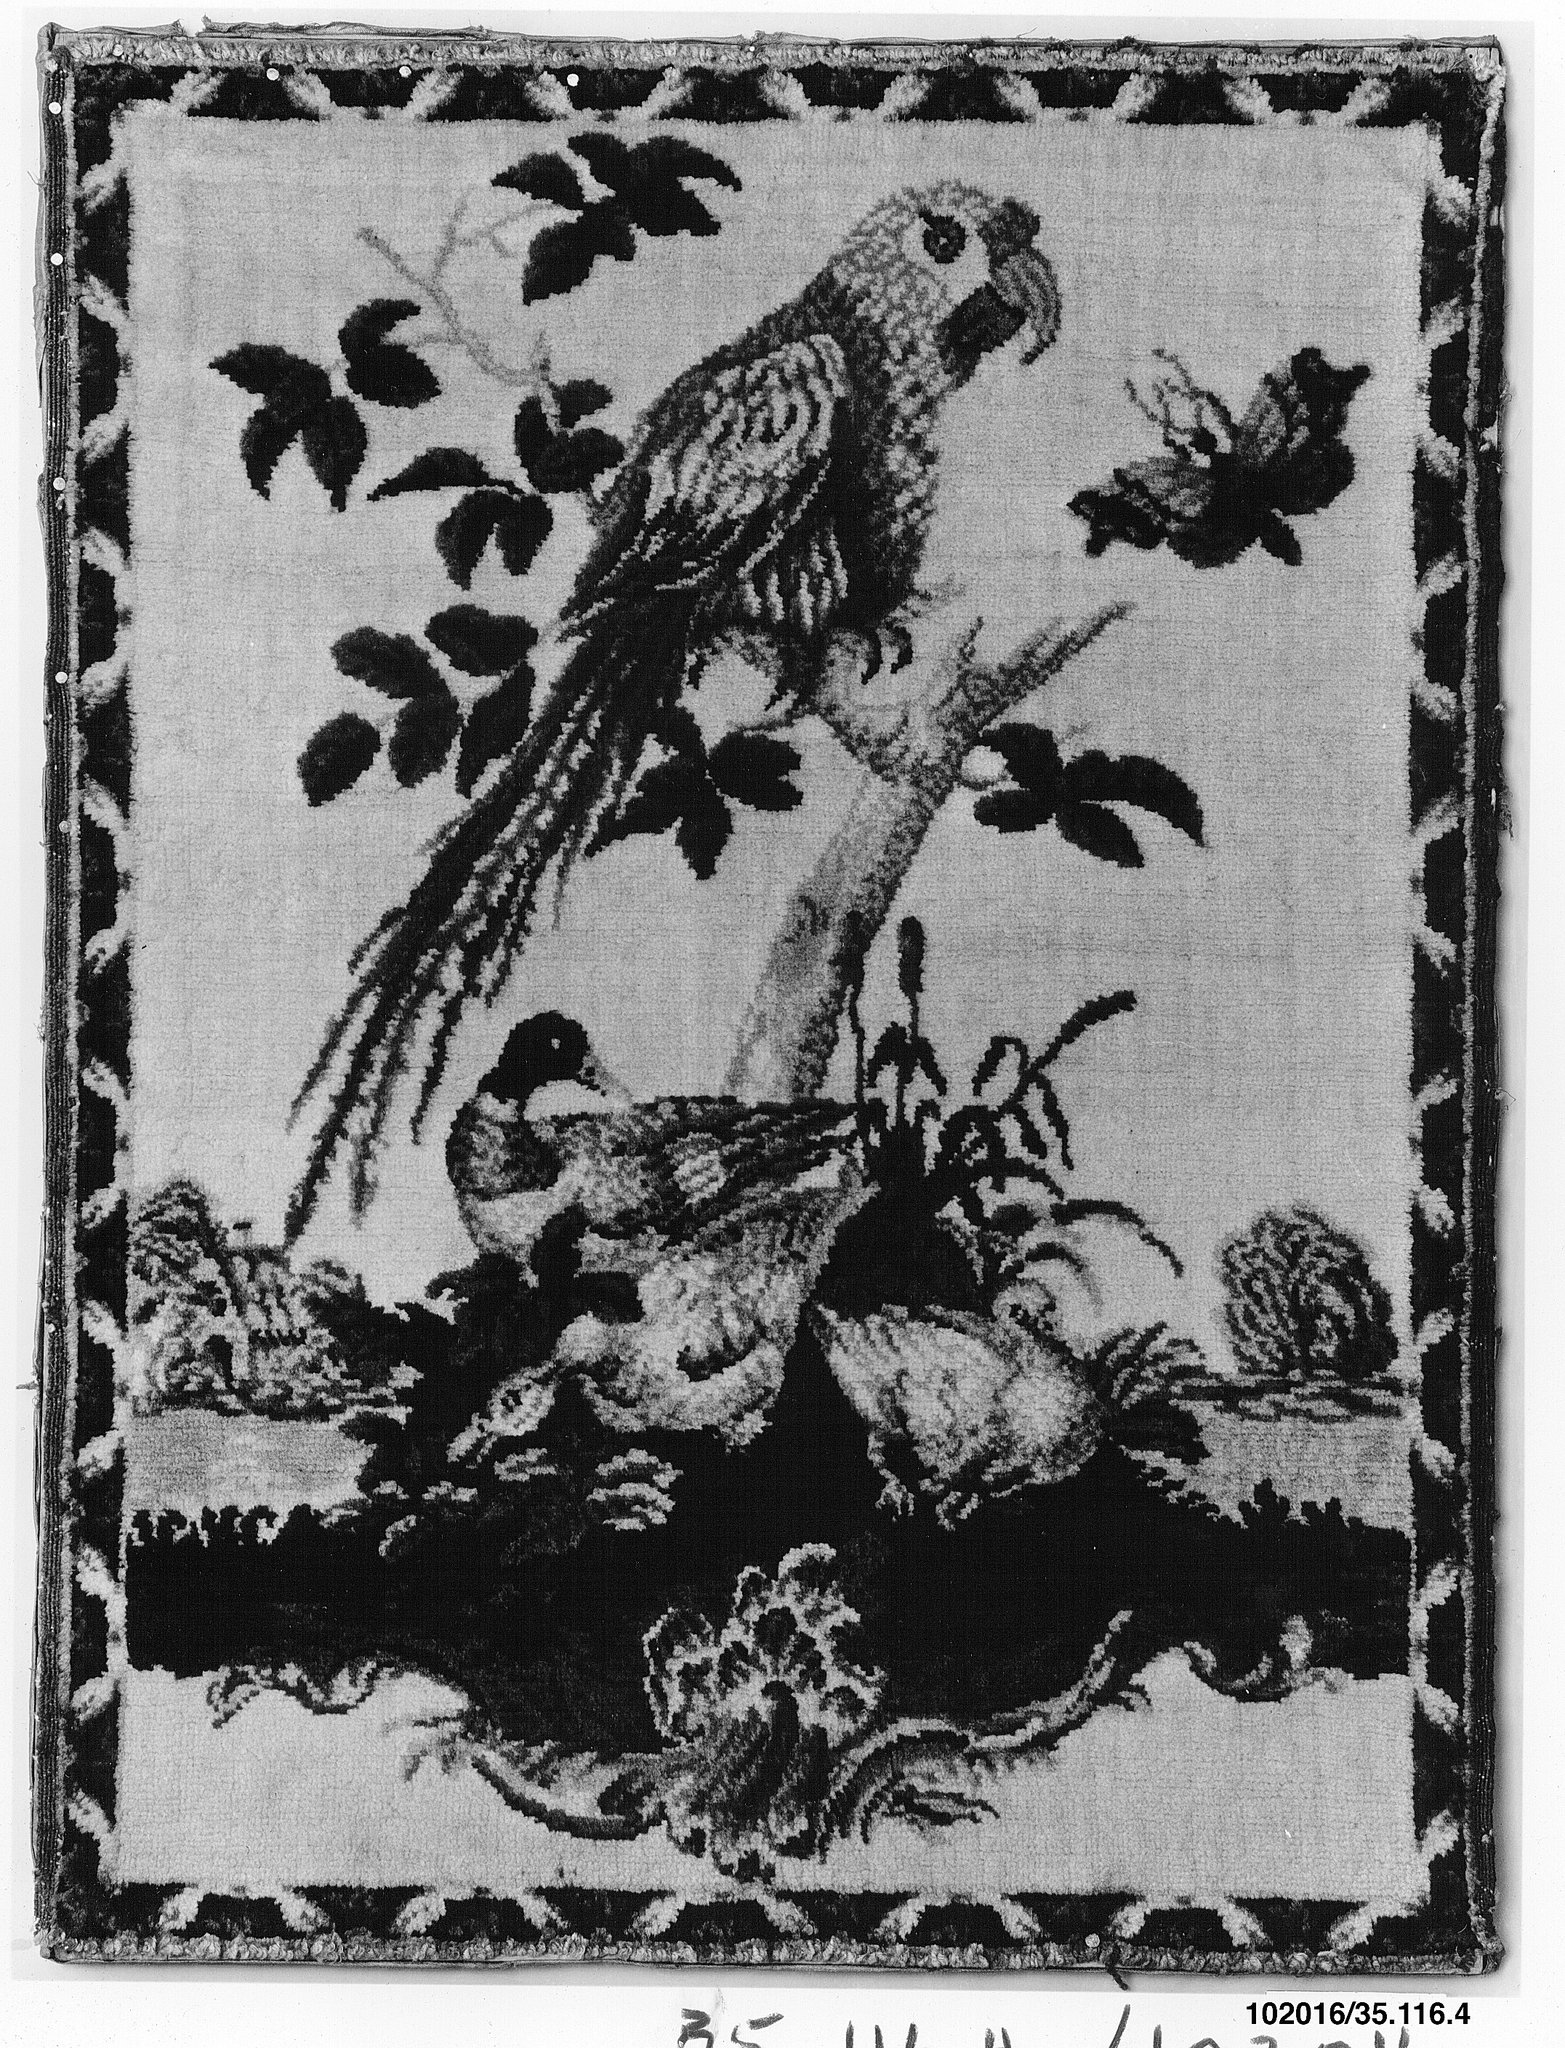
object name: panel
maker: savonnerie manufactory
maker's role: manufactory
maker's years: 1626-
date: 1730-1760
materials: wool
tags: ducks,parrots,butterflies,plants